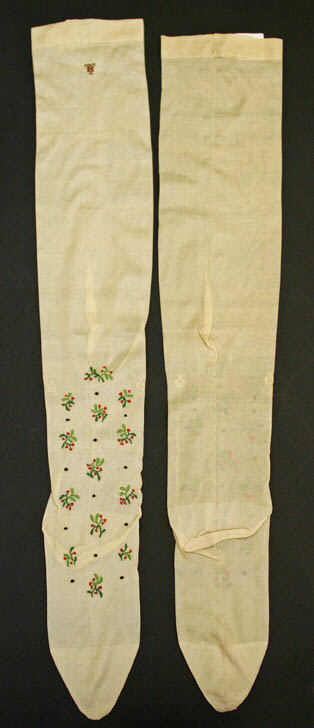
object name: stocking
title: Stockings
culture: french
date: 1867-1900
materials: silk